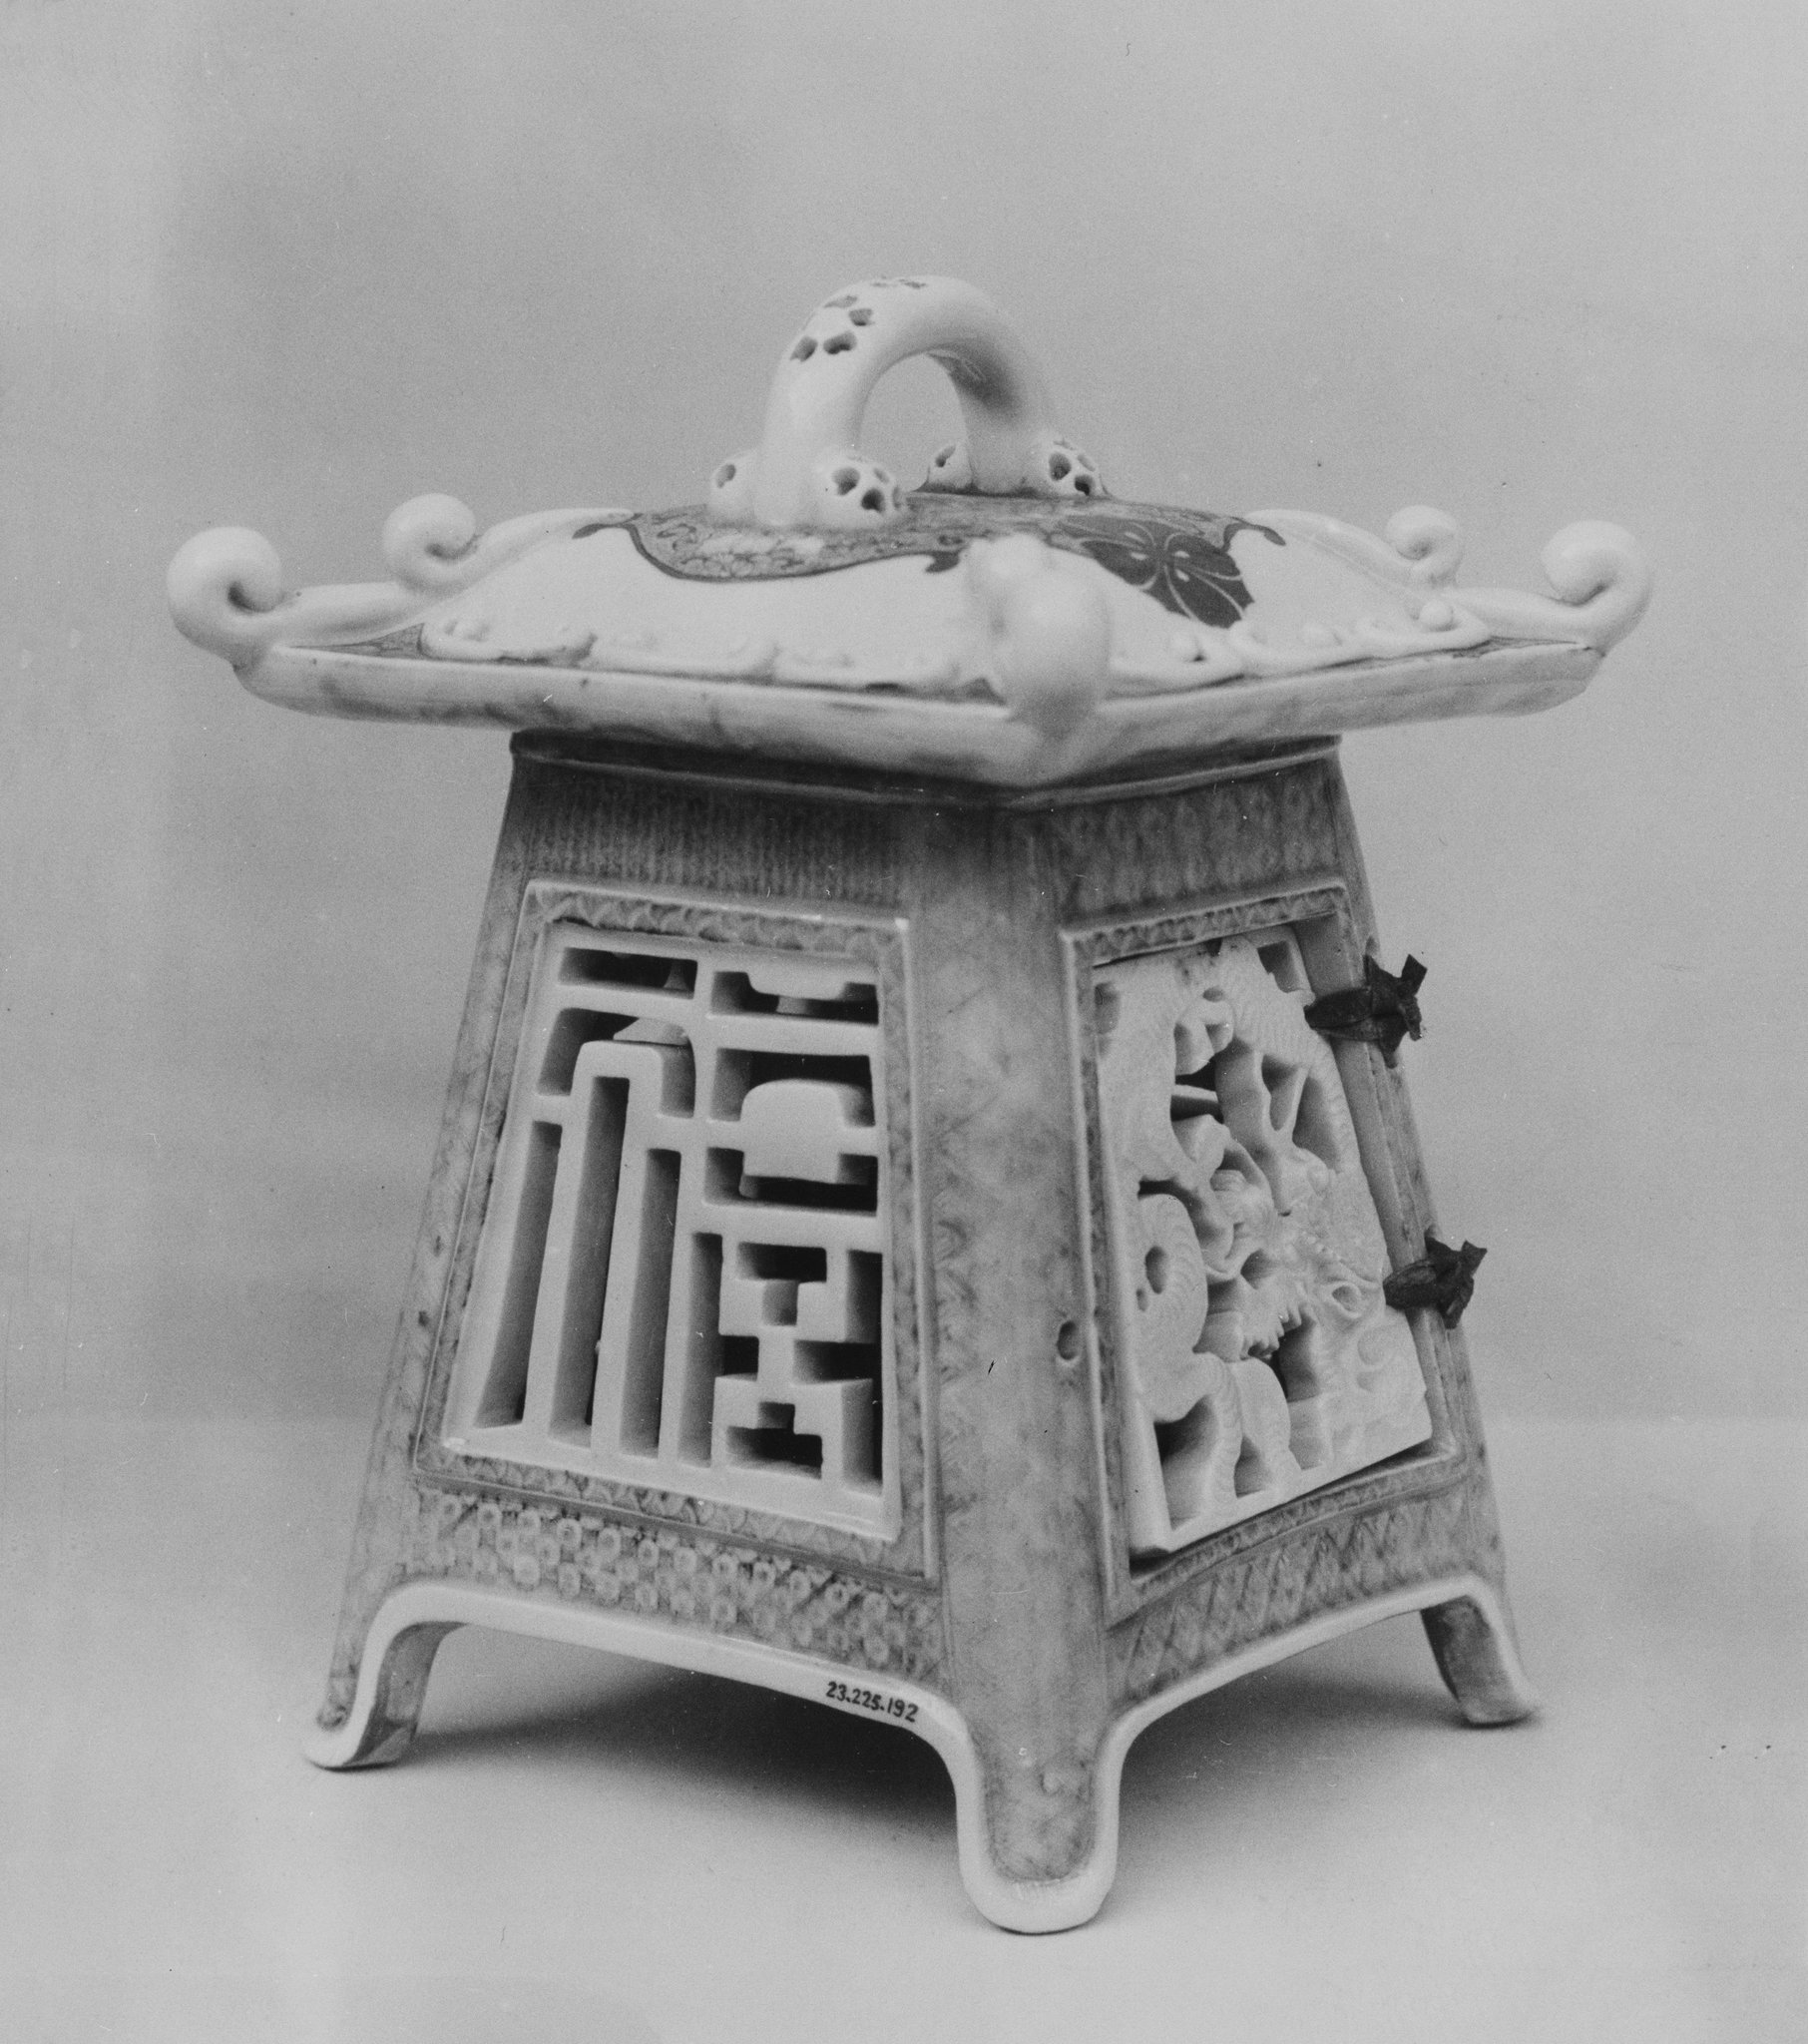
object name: hanging lamp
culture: japanese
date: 1840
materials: enamel, porcelain